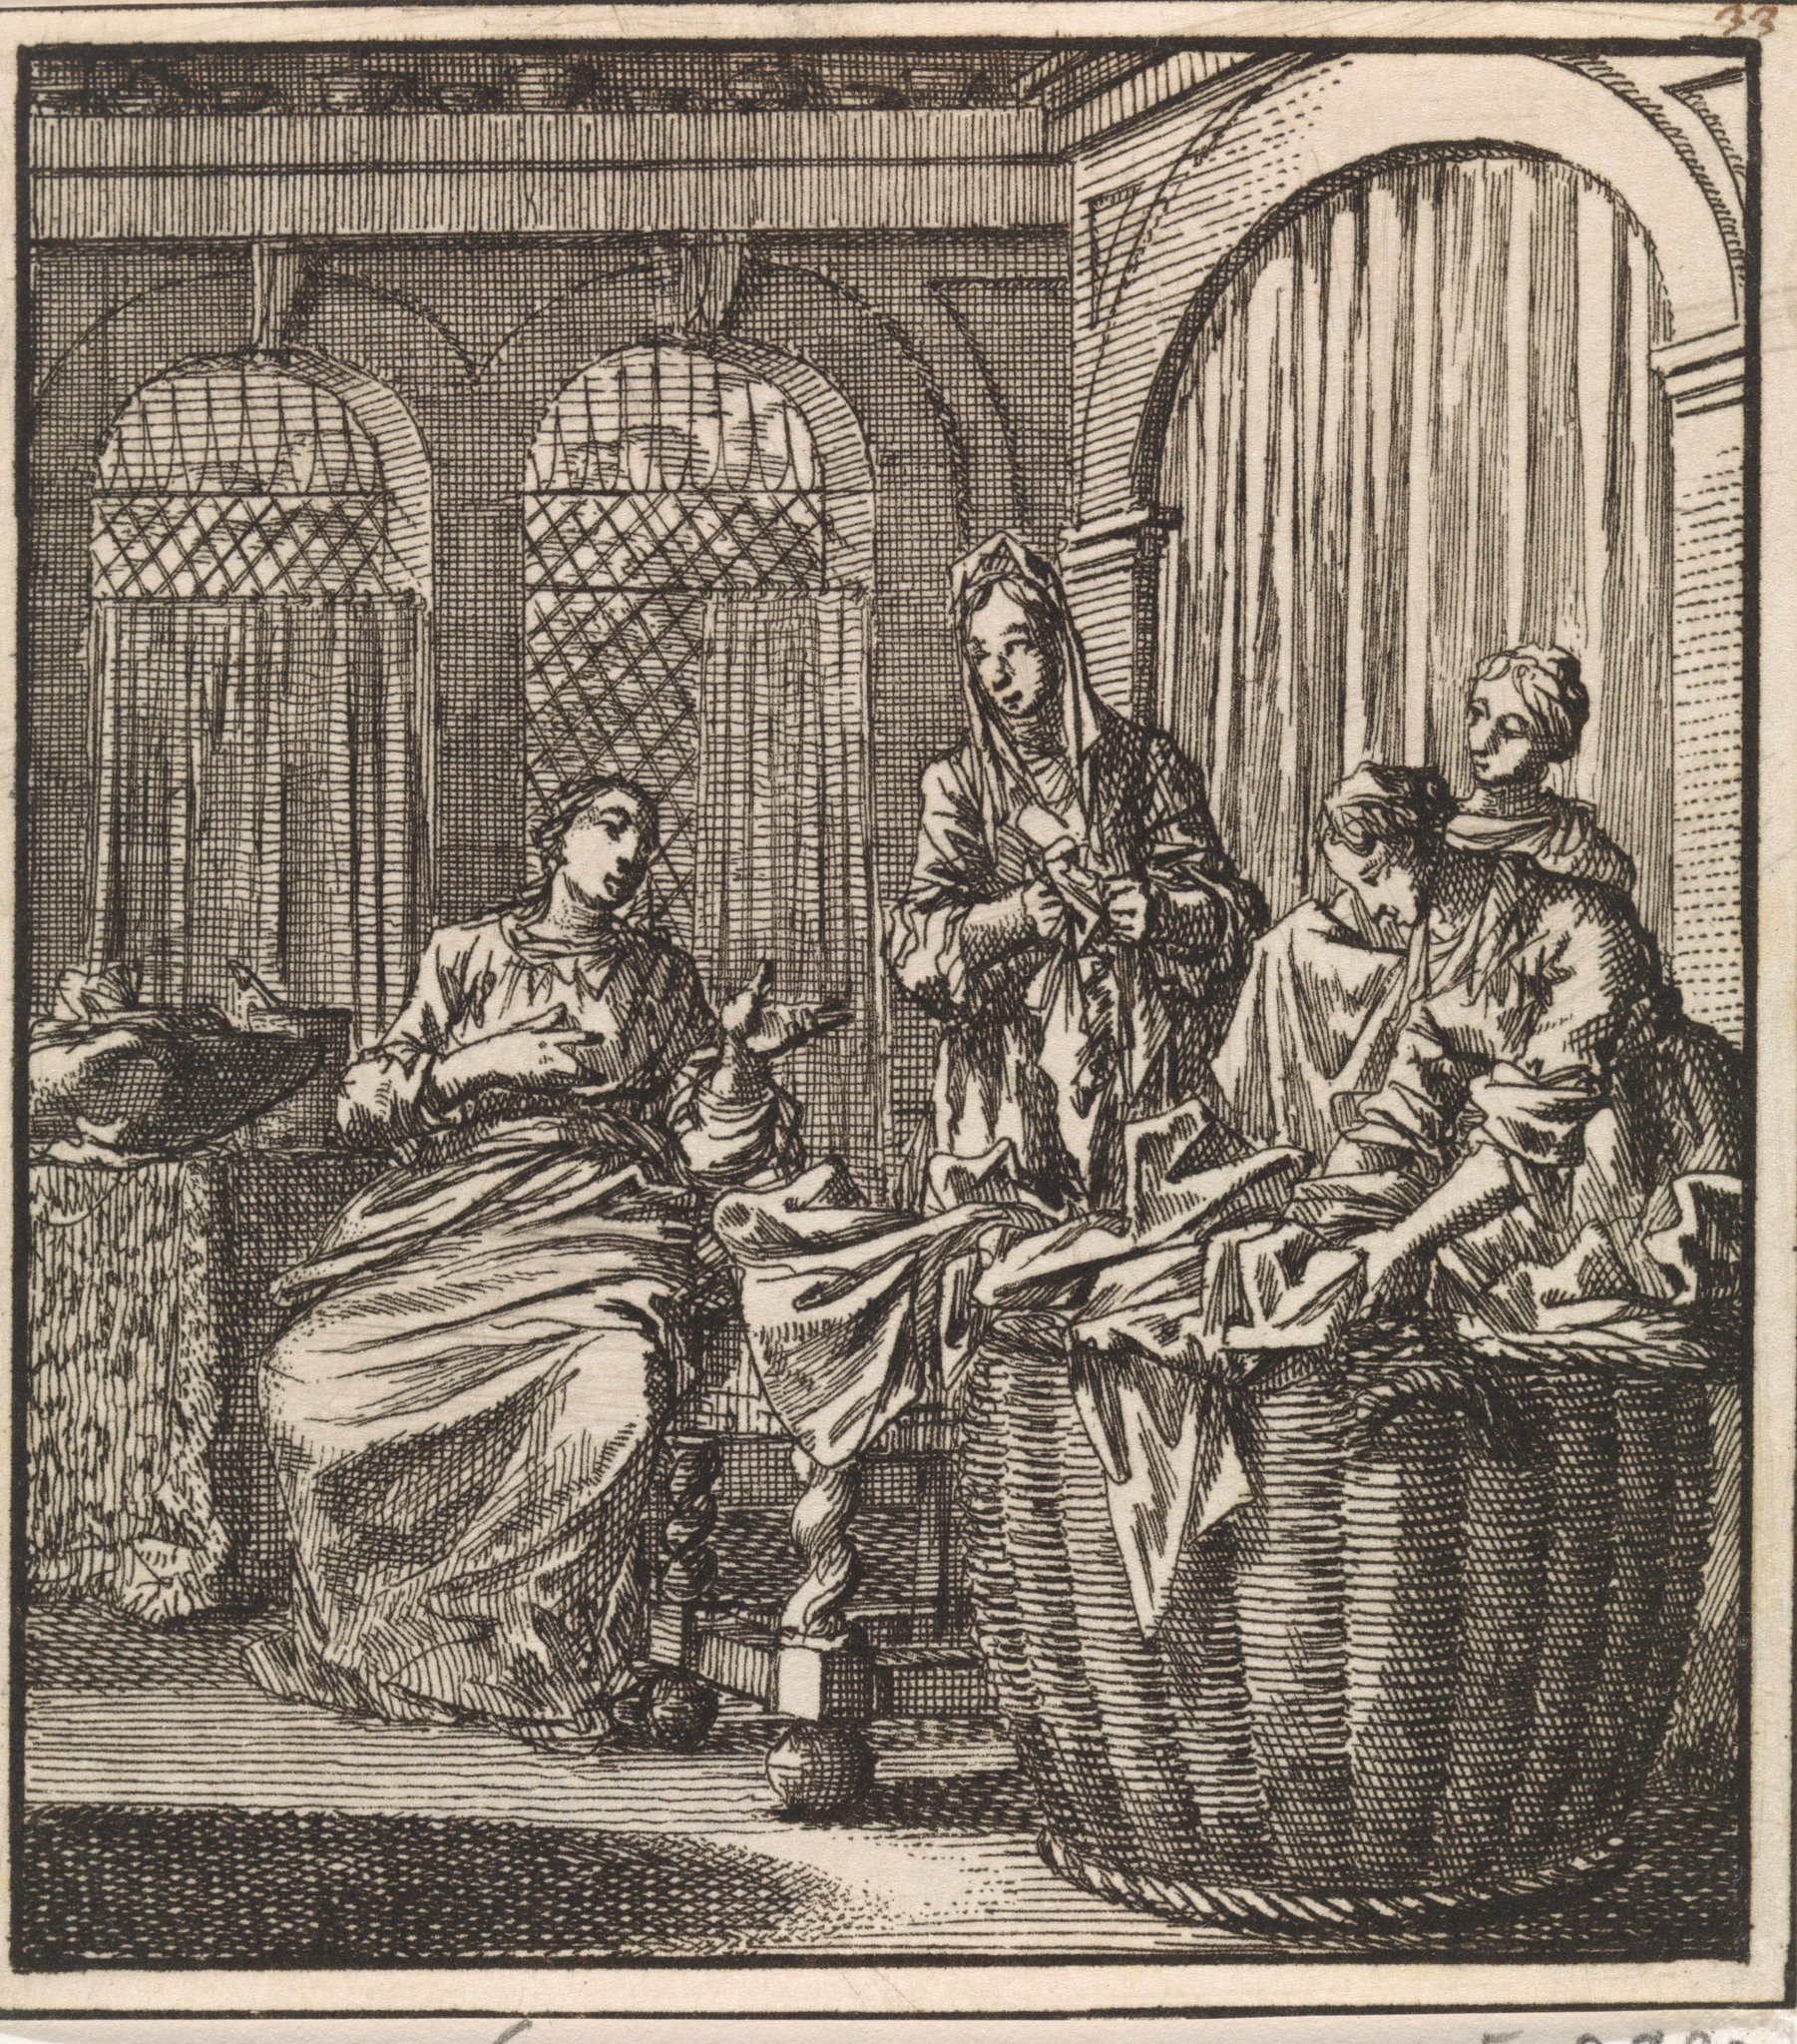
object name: print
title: De Kleerben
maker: jan luyken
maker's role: draughtsman, print maker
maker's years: 1649-1712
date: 1711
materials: paper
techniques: etching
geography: amsterdam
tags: container made of plant material other than wood: basket, wash house, home laundry, laundry room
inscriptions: collector's mark: Lugt 2228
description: Proefdruk van illustratie voor: Luyken, Jan. Het leerzaam huisraad, vertoond in vyftig konstige figuuren, met godlyke spreuken en stichtelyke verzen: Pieter Arentsz. II (wed.) en Cornelis van der Sys, 1711, p. 114.